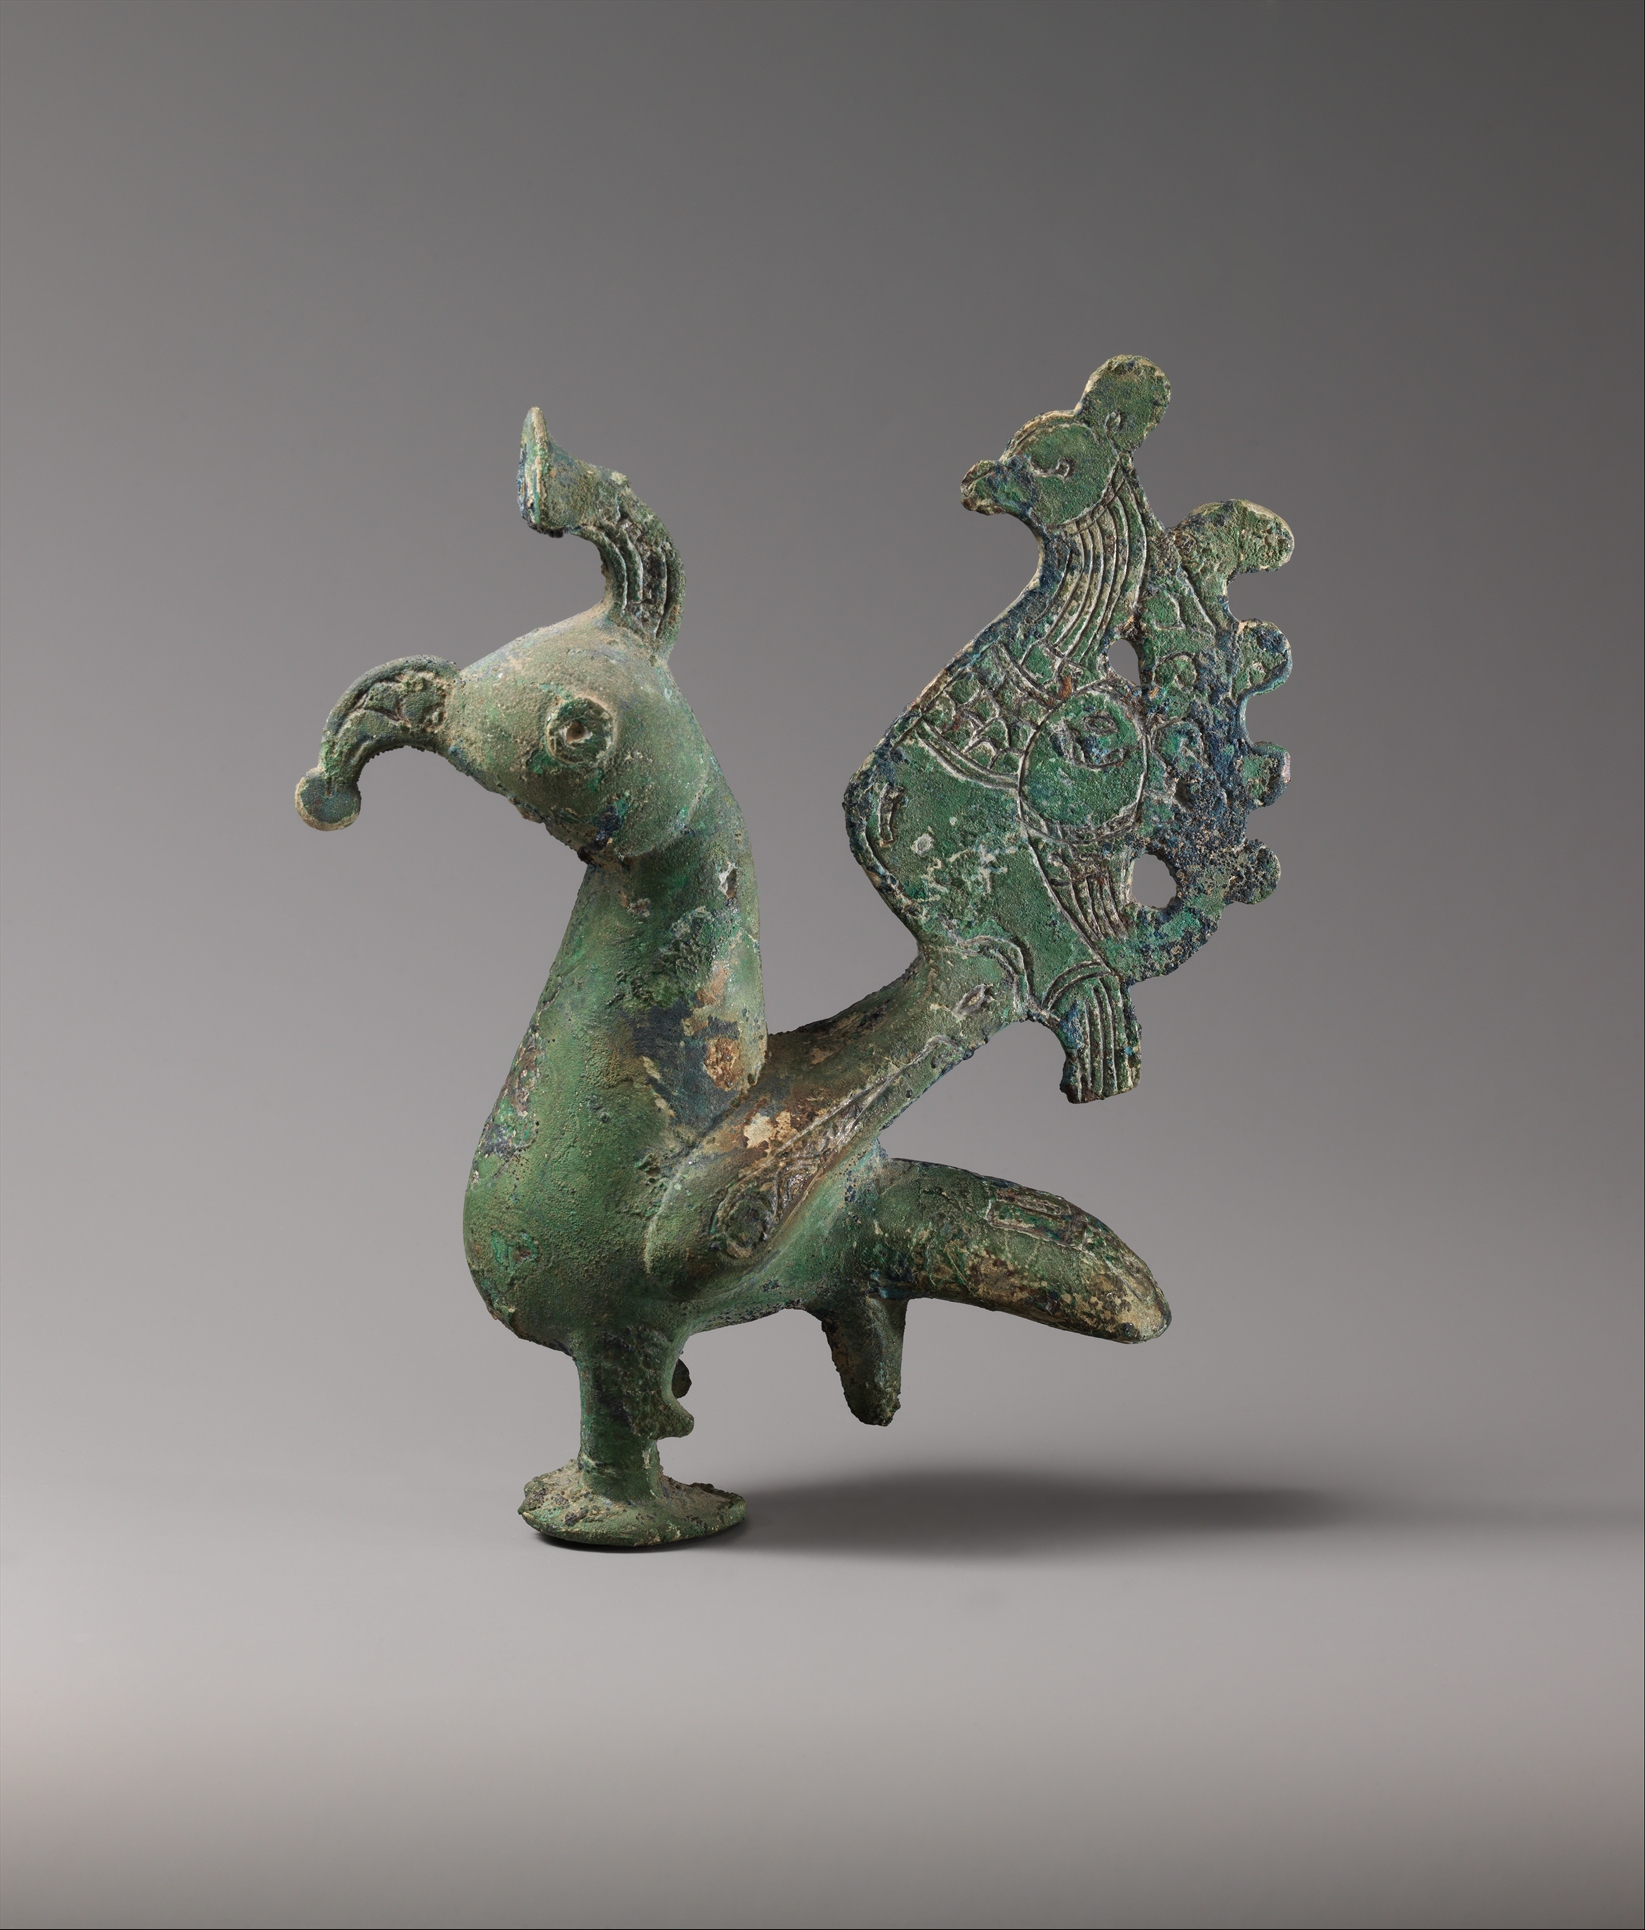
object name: finial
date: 1001-1200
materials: bronze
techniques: casting, chasing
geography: iran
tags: birds